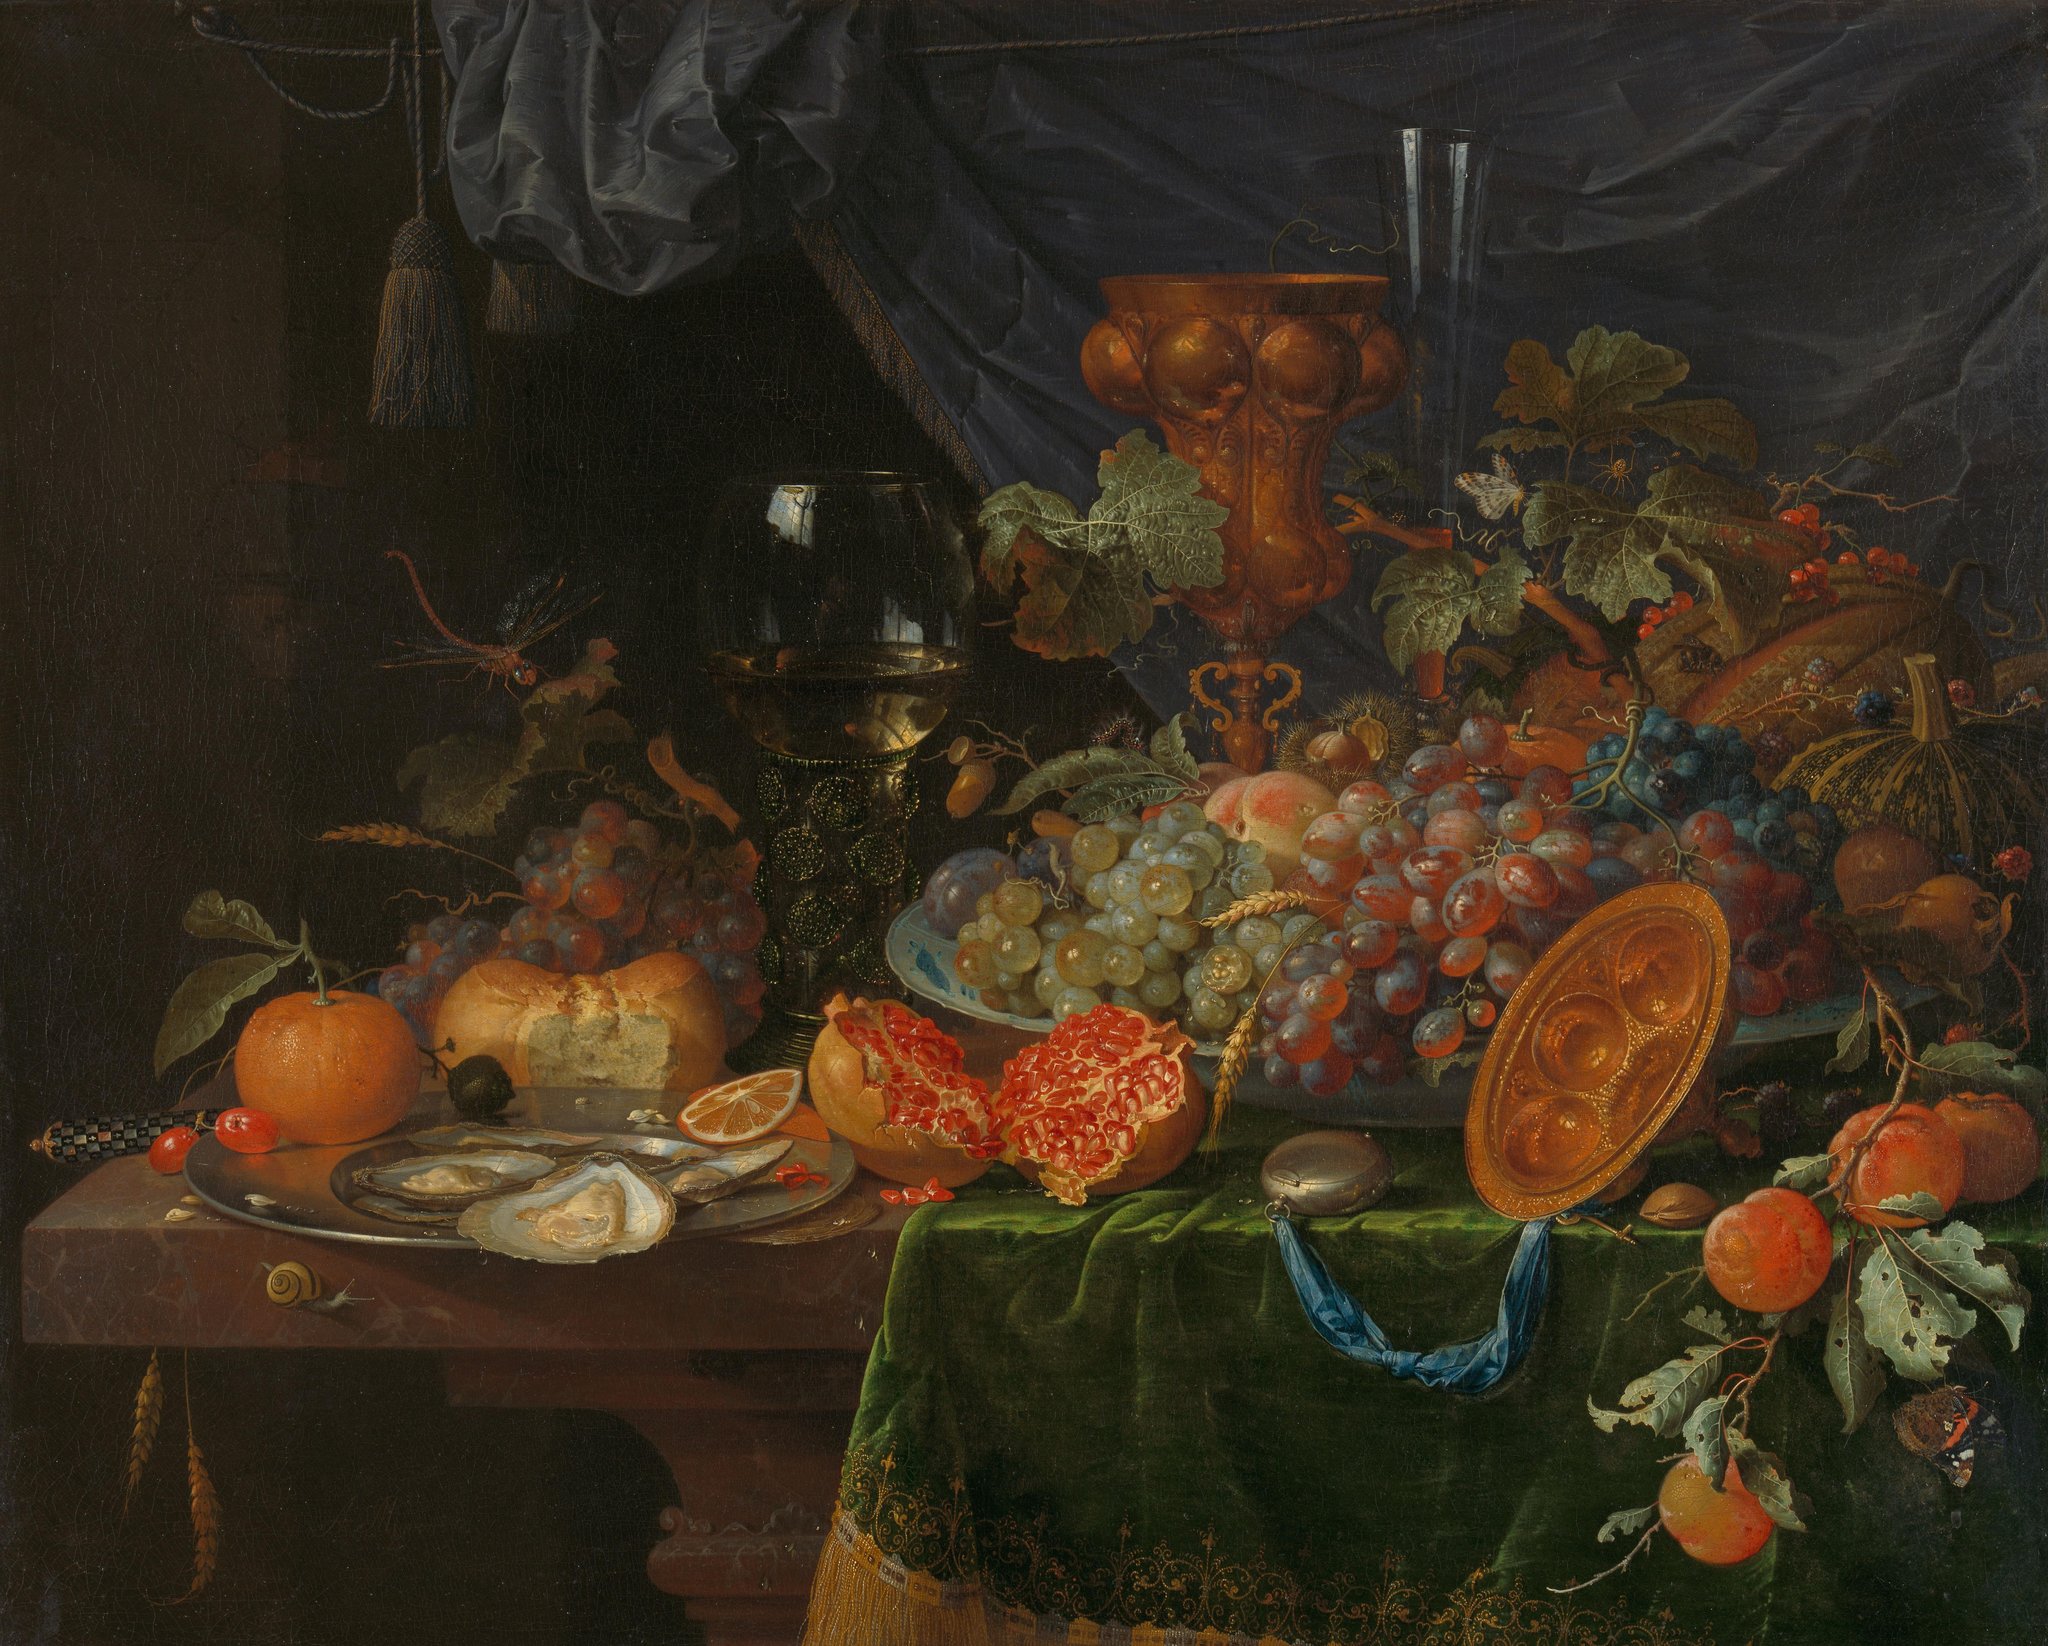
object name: painting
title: Still Life with Fruit and Oysters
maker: abraham mignon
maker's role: painter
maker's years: 1640-1679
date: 1660-1679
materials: canvas, oil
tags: fruit, molluscs: oyster, laid table as still life, watch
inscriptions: signature: ‘A. Mignon. fe.’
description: This carefully laid table likely never existed in reality. However, the food items depicted did form part of the meals enjoyed by the wealthy. They washed down fresh fruit and oysters with a glass of fine wine. Despite appearing local, many of the products and raw materials were imported from neighbouring countries. For instance, bread was baked locally, but the used grain came from countries bordering the Baltic Sea.